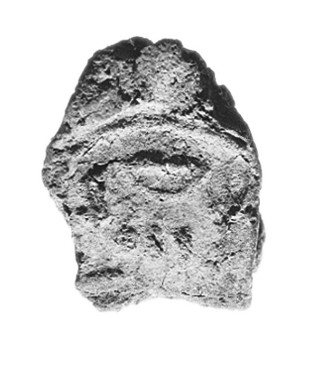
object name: sealing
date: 2030-1640 BCE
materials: clay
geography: egypt